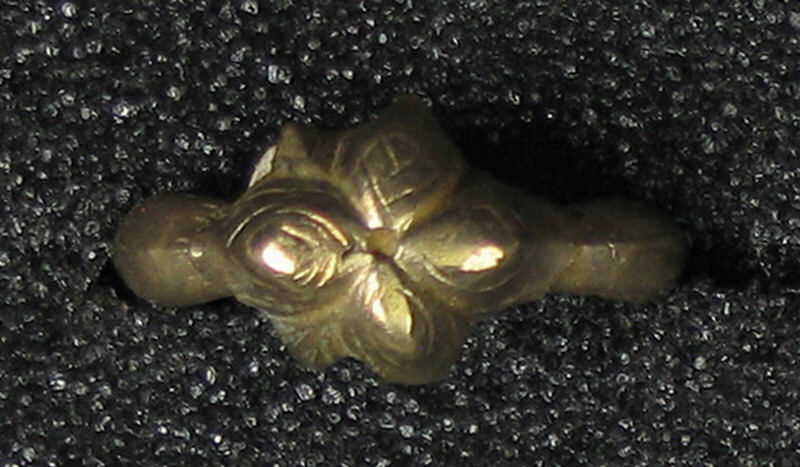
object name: ring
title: Ring in Quatrefoil Shape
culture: indonesian, central java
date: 701-1200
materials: gold